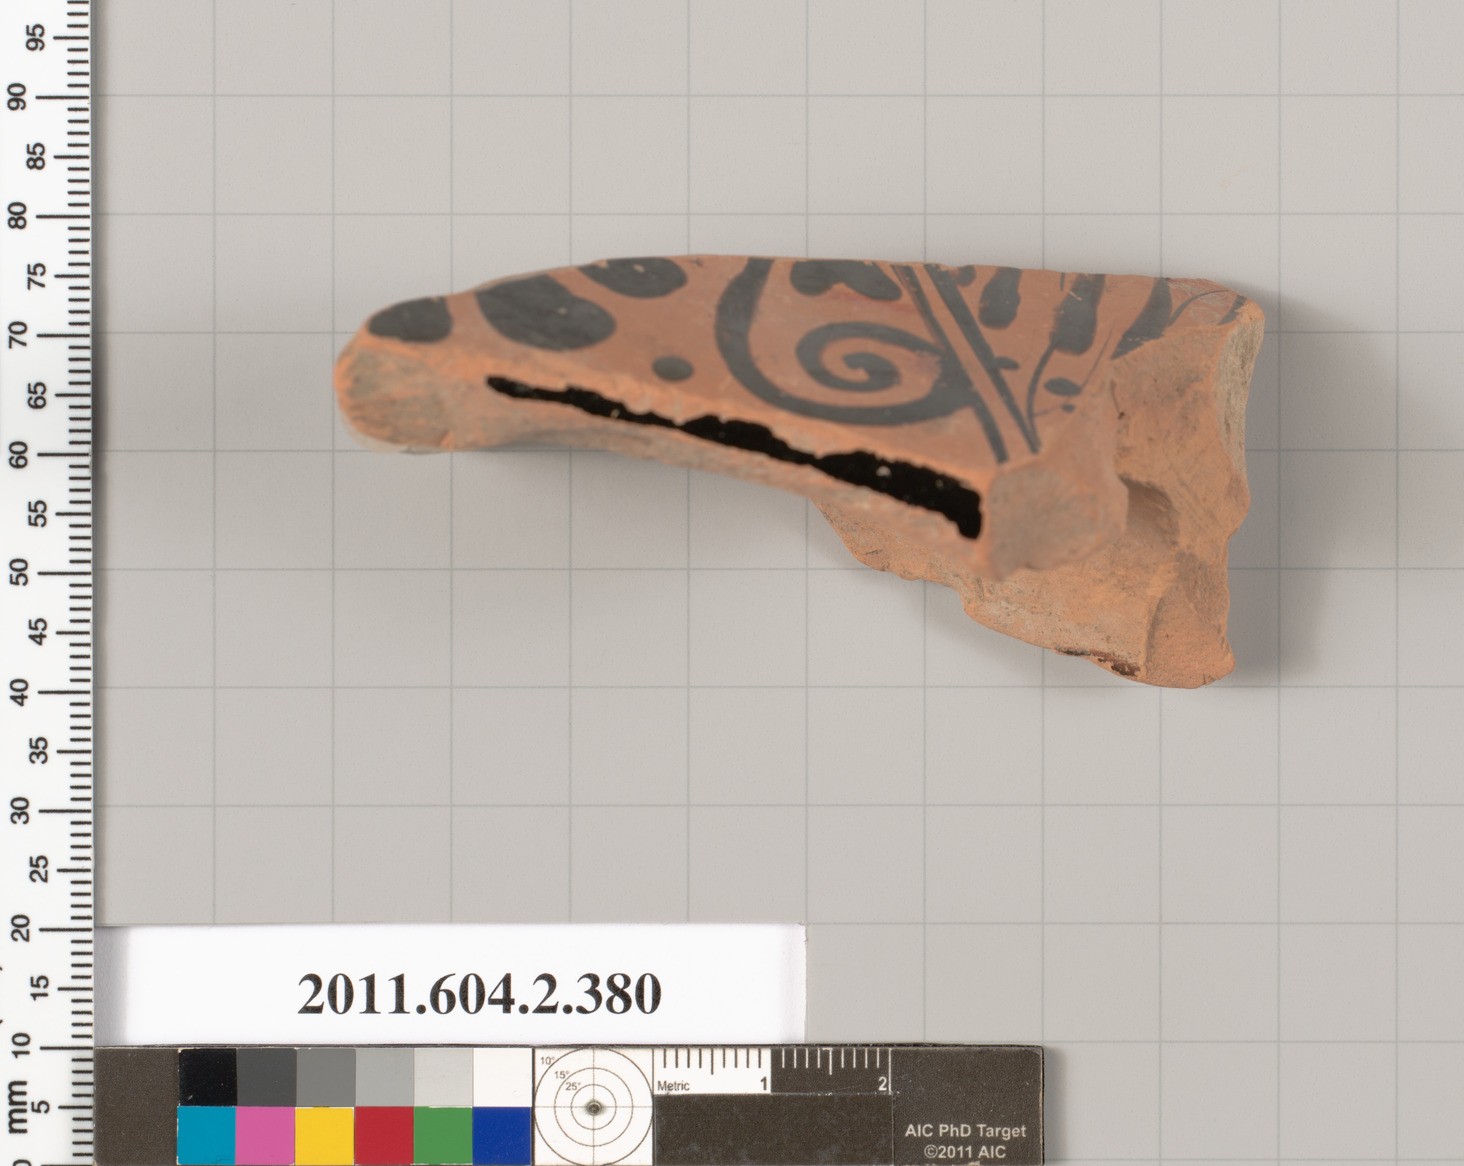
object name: column krater fragment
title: Terracotta fragment of a column-krater (bowl for mixing wine and water)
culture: greek, attic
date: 430 BCE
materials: terracotta